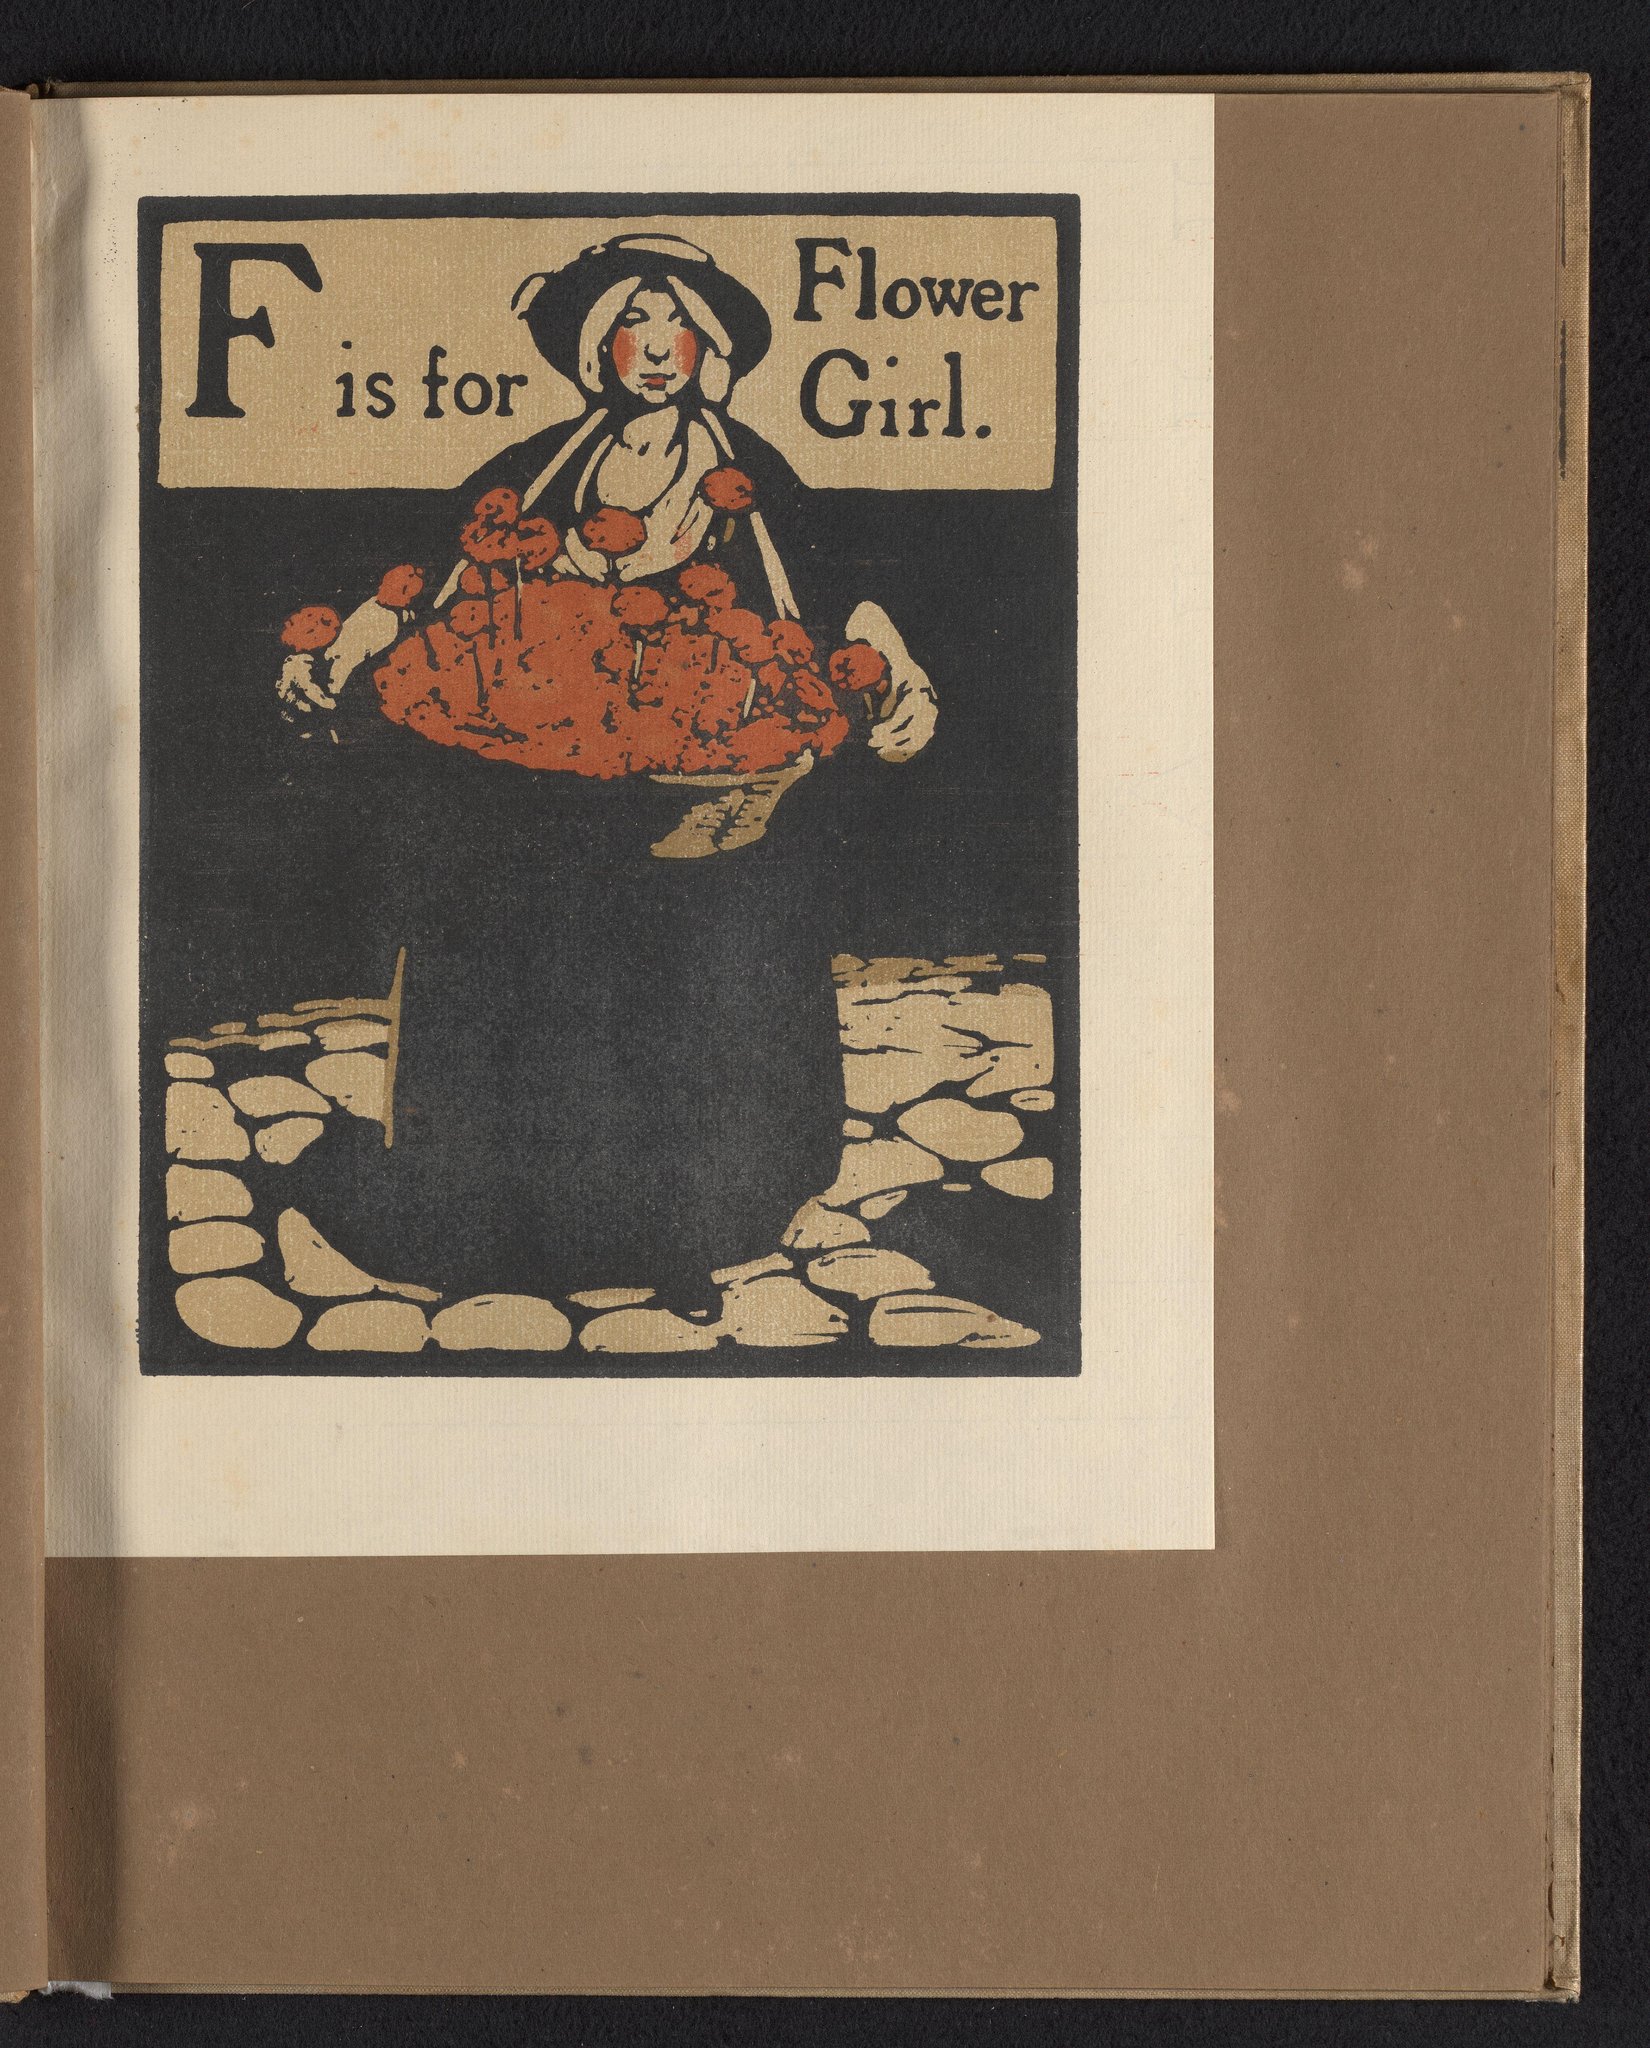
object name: print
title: An Alphabet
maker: william heinemann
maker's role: publisher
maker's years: 1863-1920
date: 1898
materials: paper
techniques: lithograph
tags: dandy, beau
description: De serie met lithografieën is gemaakt naar ontwerpen van houtsneden door William Nicholson.